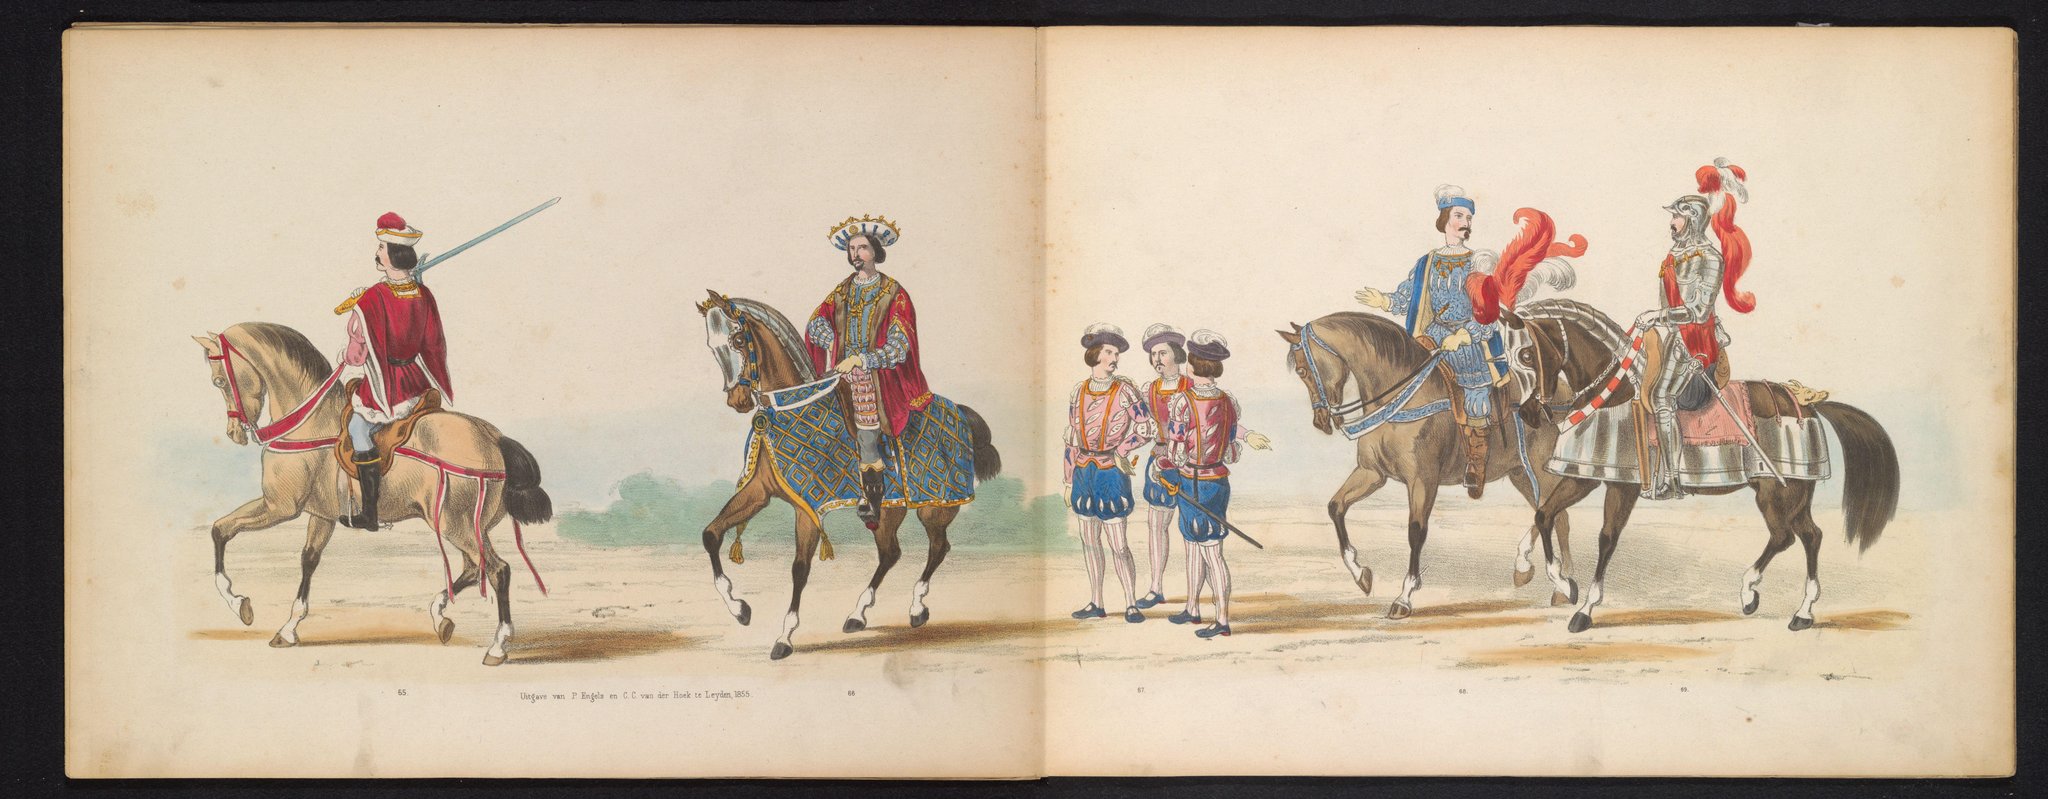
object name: print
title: Gecostumeerde optogt gehouden door de leden van het Leidsche studenten-corps den 12den Junij 1855, ter viering van den 280sten verjaardag der Leidsche Hoogeschool, voorstellende de intrede van Karel V binnen Dordrecht op den 3den Junij 1515, bij gelegenheid zijner huldiging tot Graaf van Holland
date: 1855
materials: paper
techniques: hand coloring, lithograph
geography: netherlands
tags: ghent, charles v (holy roman emperor and king of spain), students' pageant, costumes used in pageants, leiden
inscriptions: date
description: Historische gekostumeerde optocht van de studenten van de Hogeschool van Leiden op 12 juni 1855 ter gelegenheid van het 280-jarig bestaan van de Hogeschool. De optocht verbeeldt de intocht van keizer Karel V te Dordrecht op 3 juni 1515 bij zijn huldiging tot graaf van Holland. Achtste plaat met de groepen genummerd 65-69. Onderdeel van een serie van veertien aanelkaar geplakte bladen.